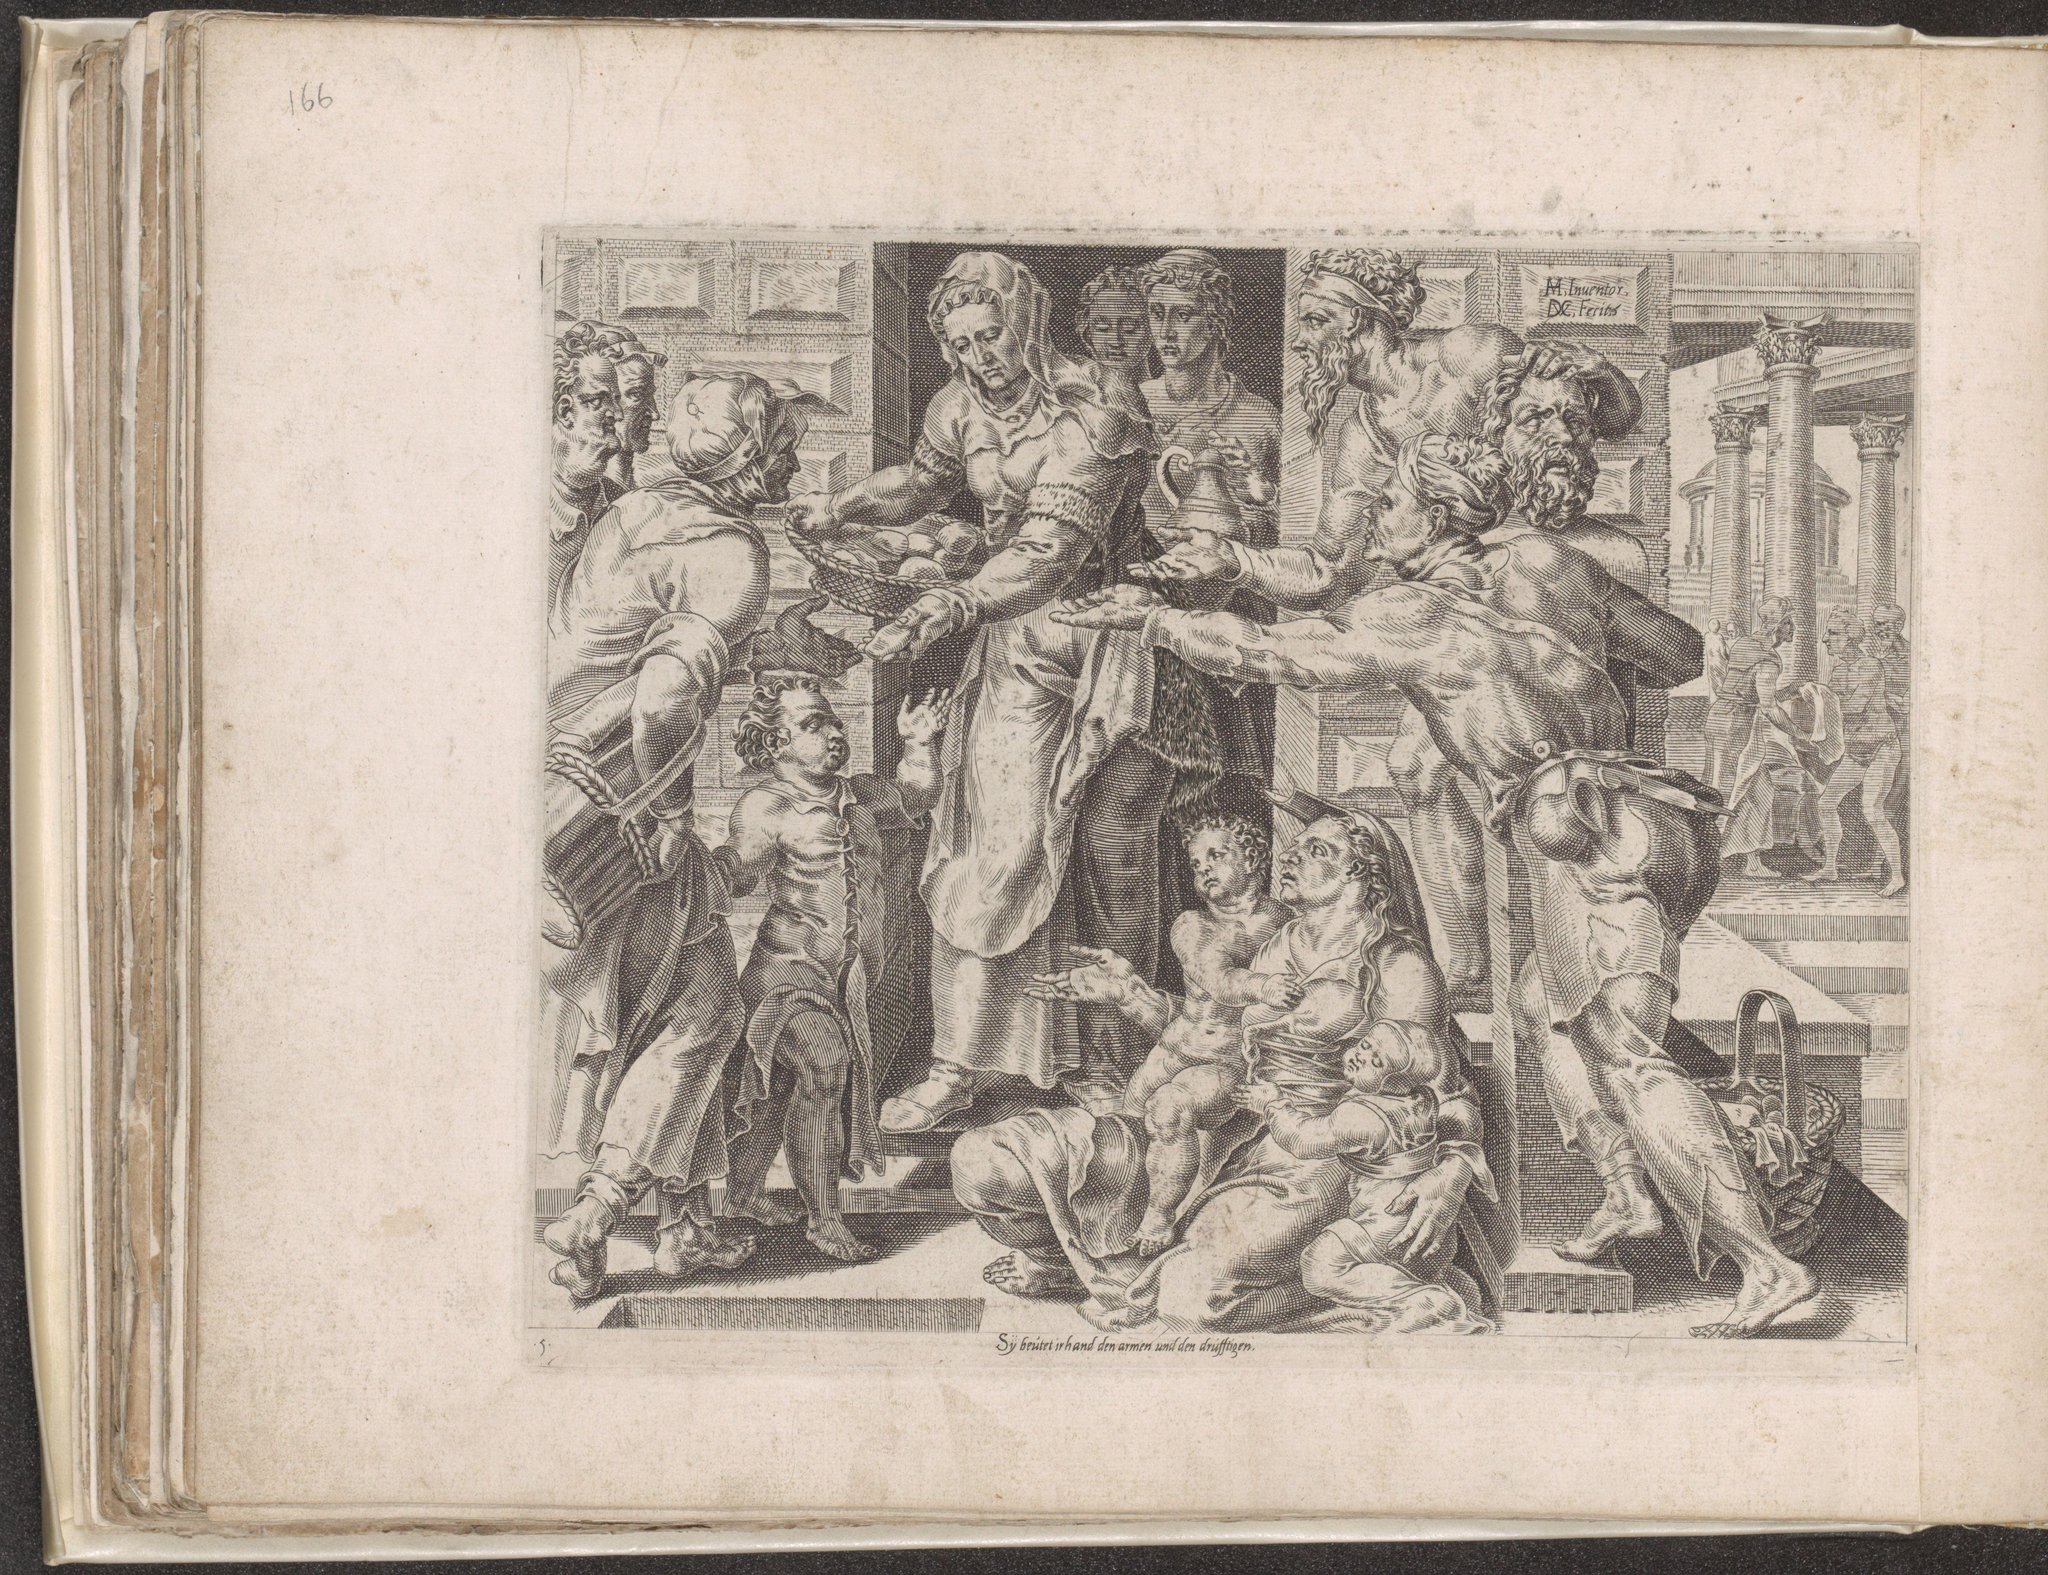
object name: print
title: Lof op de deugdzame huisvrouw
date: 1555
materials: paper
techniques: engraving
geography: groningen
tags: charity, 'caritas'; 'carità' (ripa) ~ one of the three theological virtues, the book of proverbs (with book chapter:verse), feeding the hungry, 'esuriens cibatur' ~ one of the (seven) acts of mercy, clothing the naked, 'nudus vestitur' ~ one of the (seven) acts of mercy, ideal wife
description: De deugdzame vrouw deelt brood uit aan de armen. Op de achtergrond kleedt de deugdzame vrouw de naakten. De prent is gebaseerd op Spreuken 31:20: 'Haar handen strekt zij uit naar de behoeftigen, ze geeft de armen hulp'. Onder de voorstelling een parafrase van dit Bijbelvers in het Duits. Deze prent maakt deel uit van een album.